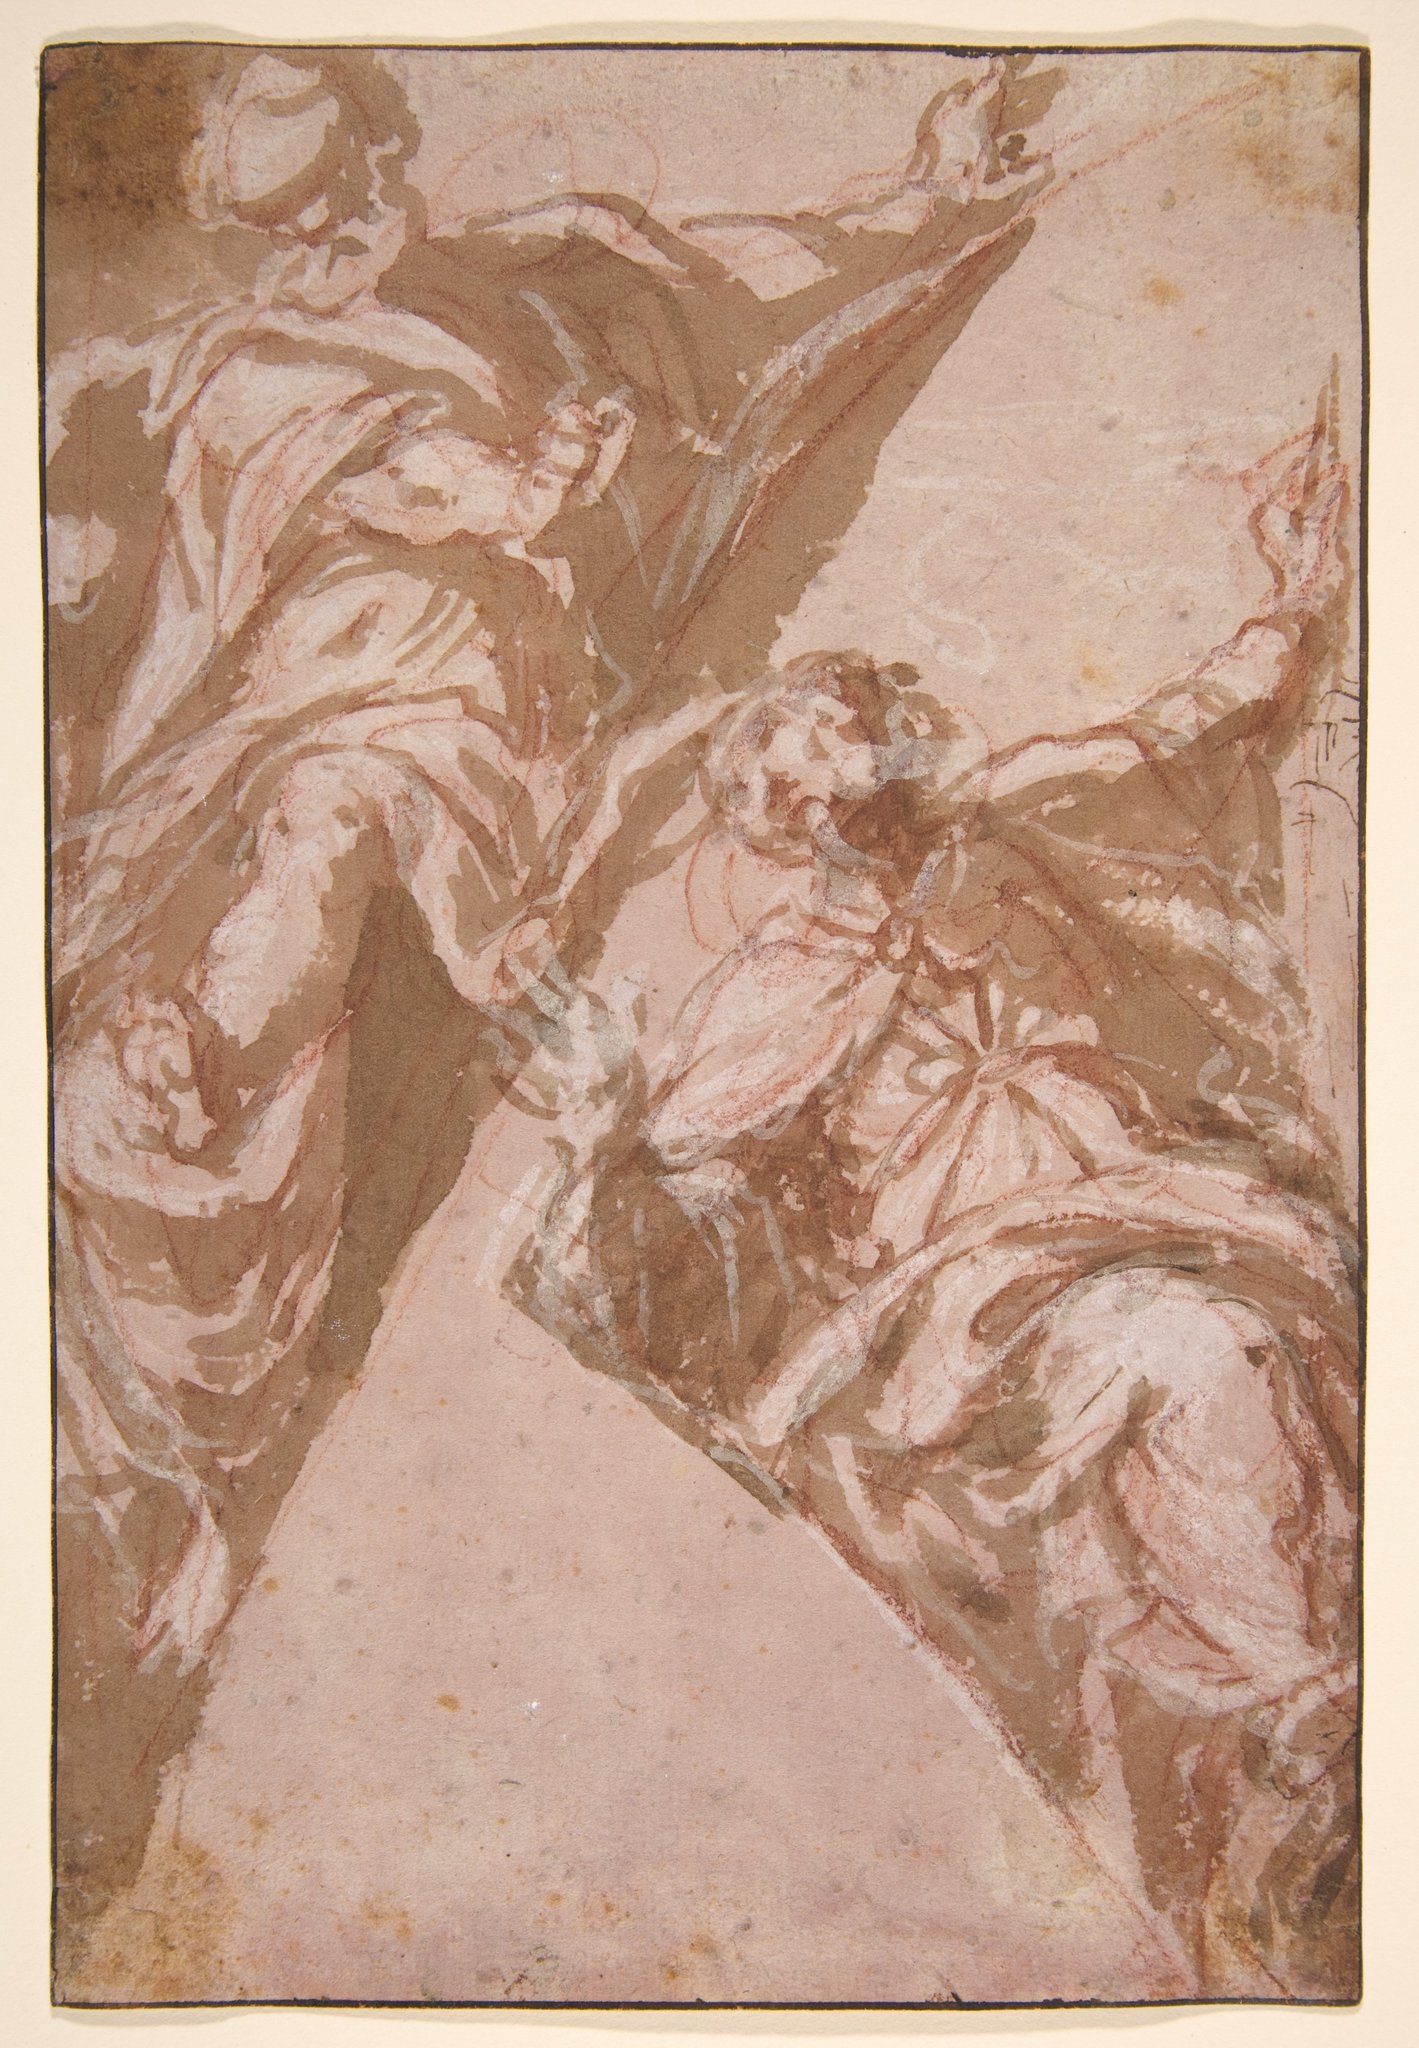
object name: drawing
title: Two Seated Male Figures Within Spandrels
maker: andrea schiavone (andrea meldola)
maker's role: artist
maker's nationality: italian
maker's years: 1510-1563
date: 1501-1600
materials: chalk, gouache, ink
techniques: brush, highlighting, pen, wash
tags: men